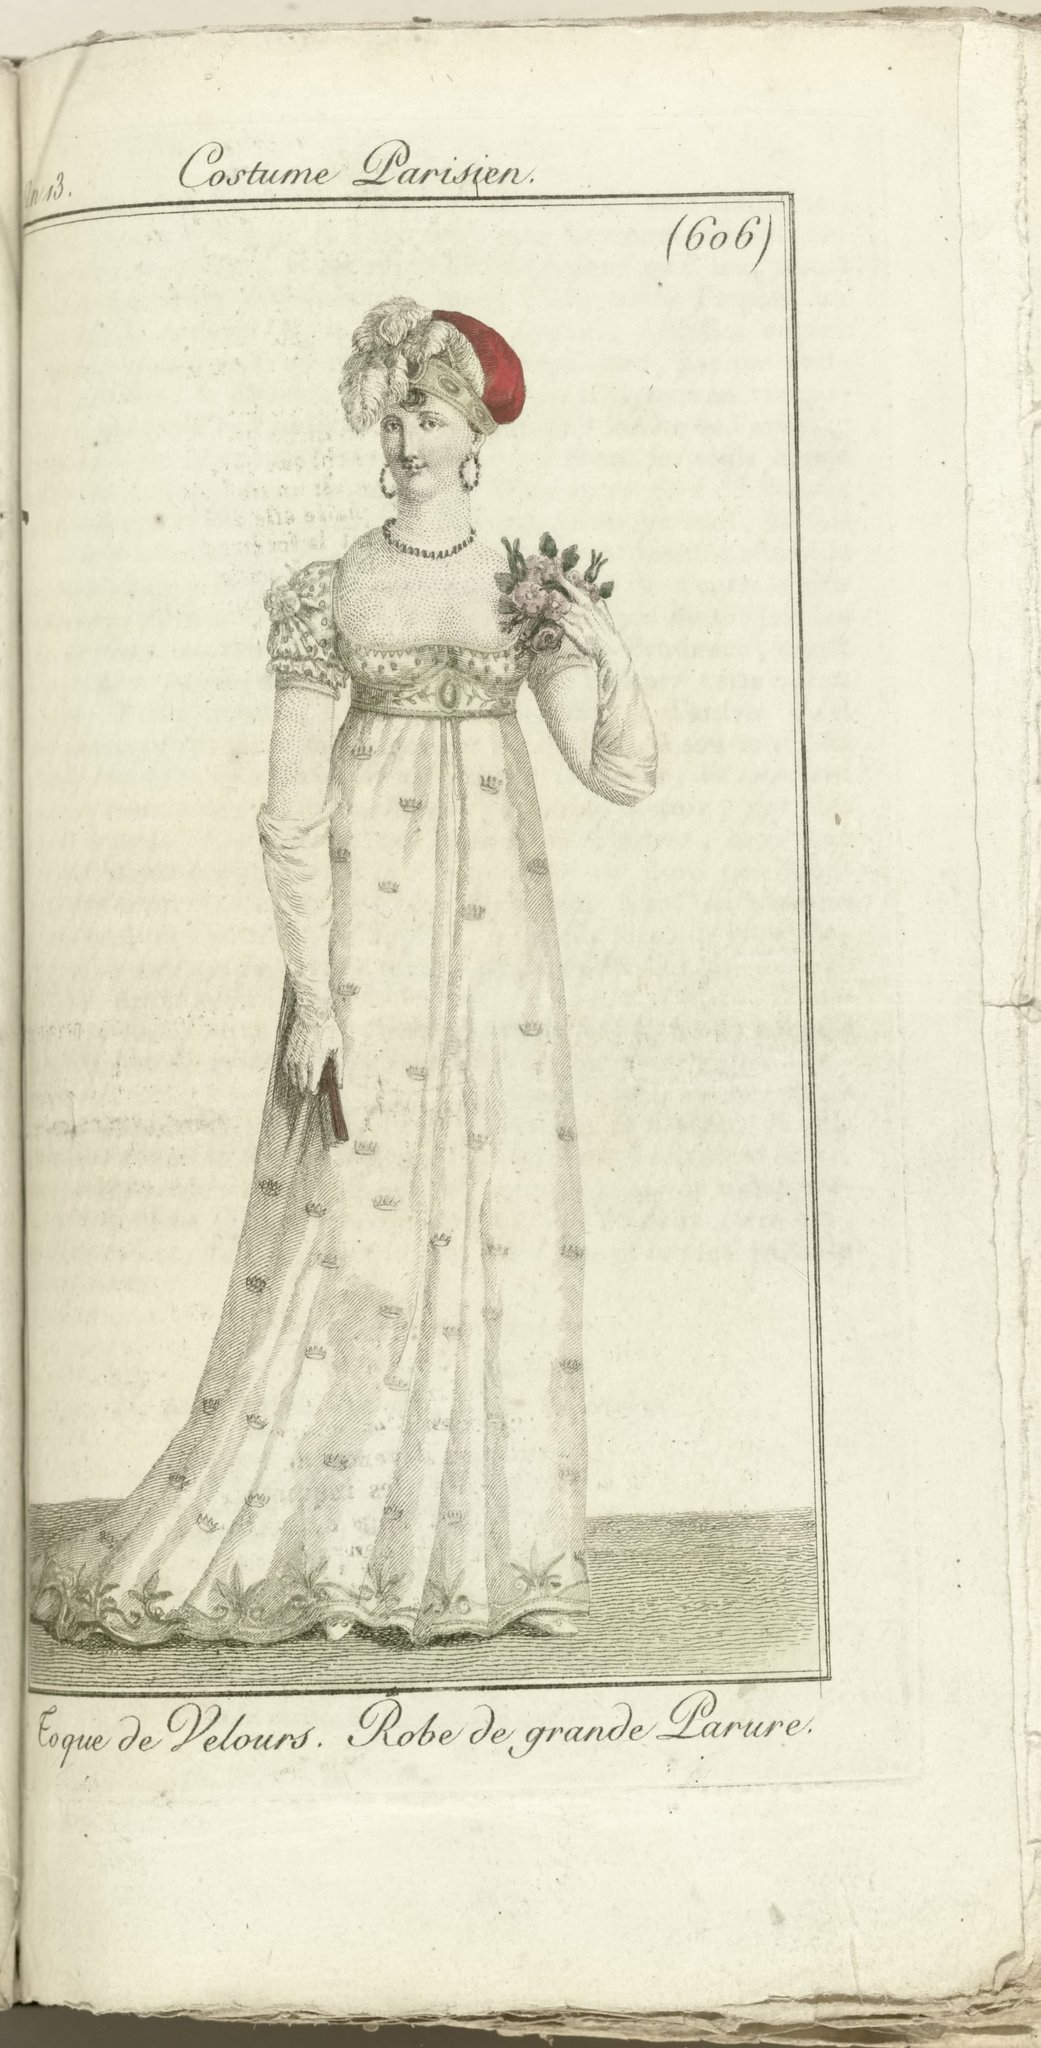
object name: fashion print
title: Journal des Dames et des Modes, Costume Parisien, 1805, An 13 (606) Toque de Velours. Robe de Grande Parure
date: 1805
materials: paper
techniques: engraving, hand coloring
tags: head-gear: toque (+ women's clothes), gloves, mittens (long gloves) (+ women's clothes), fashion plates, dress, gown (+ women's clothes), fan (+ women's clothes), pearl; pearl necklace (+ women's clothes)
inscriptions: title: ‘Toque de Velours. Robe de Grande Parure’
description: Vrouw van voren gezien, in een "robe de grande parure". Op het hoofd een toque van fluweel, versierd met veren. Tuiltje bloemen in de linker, kleine dichtgevouwen waaier in de rechterhand. De prent maakt deel uit van het modetijdschrift Journal des Dames et des Modes, uitgegeven door Pierre de la Mésangère, Parijs, 1797-1839.